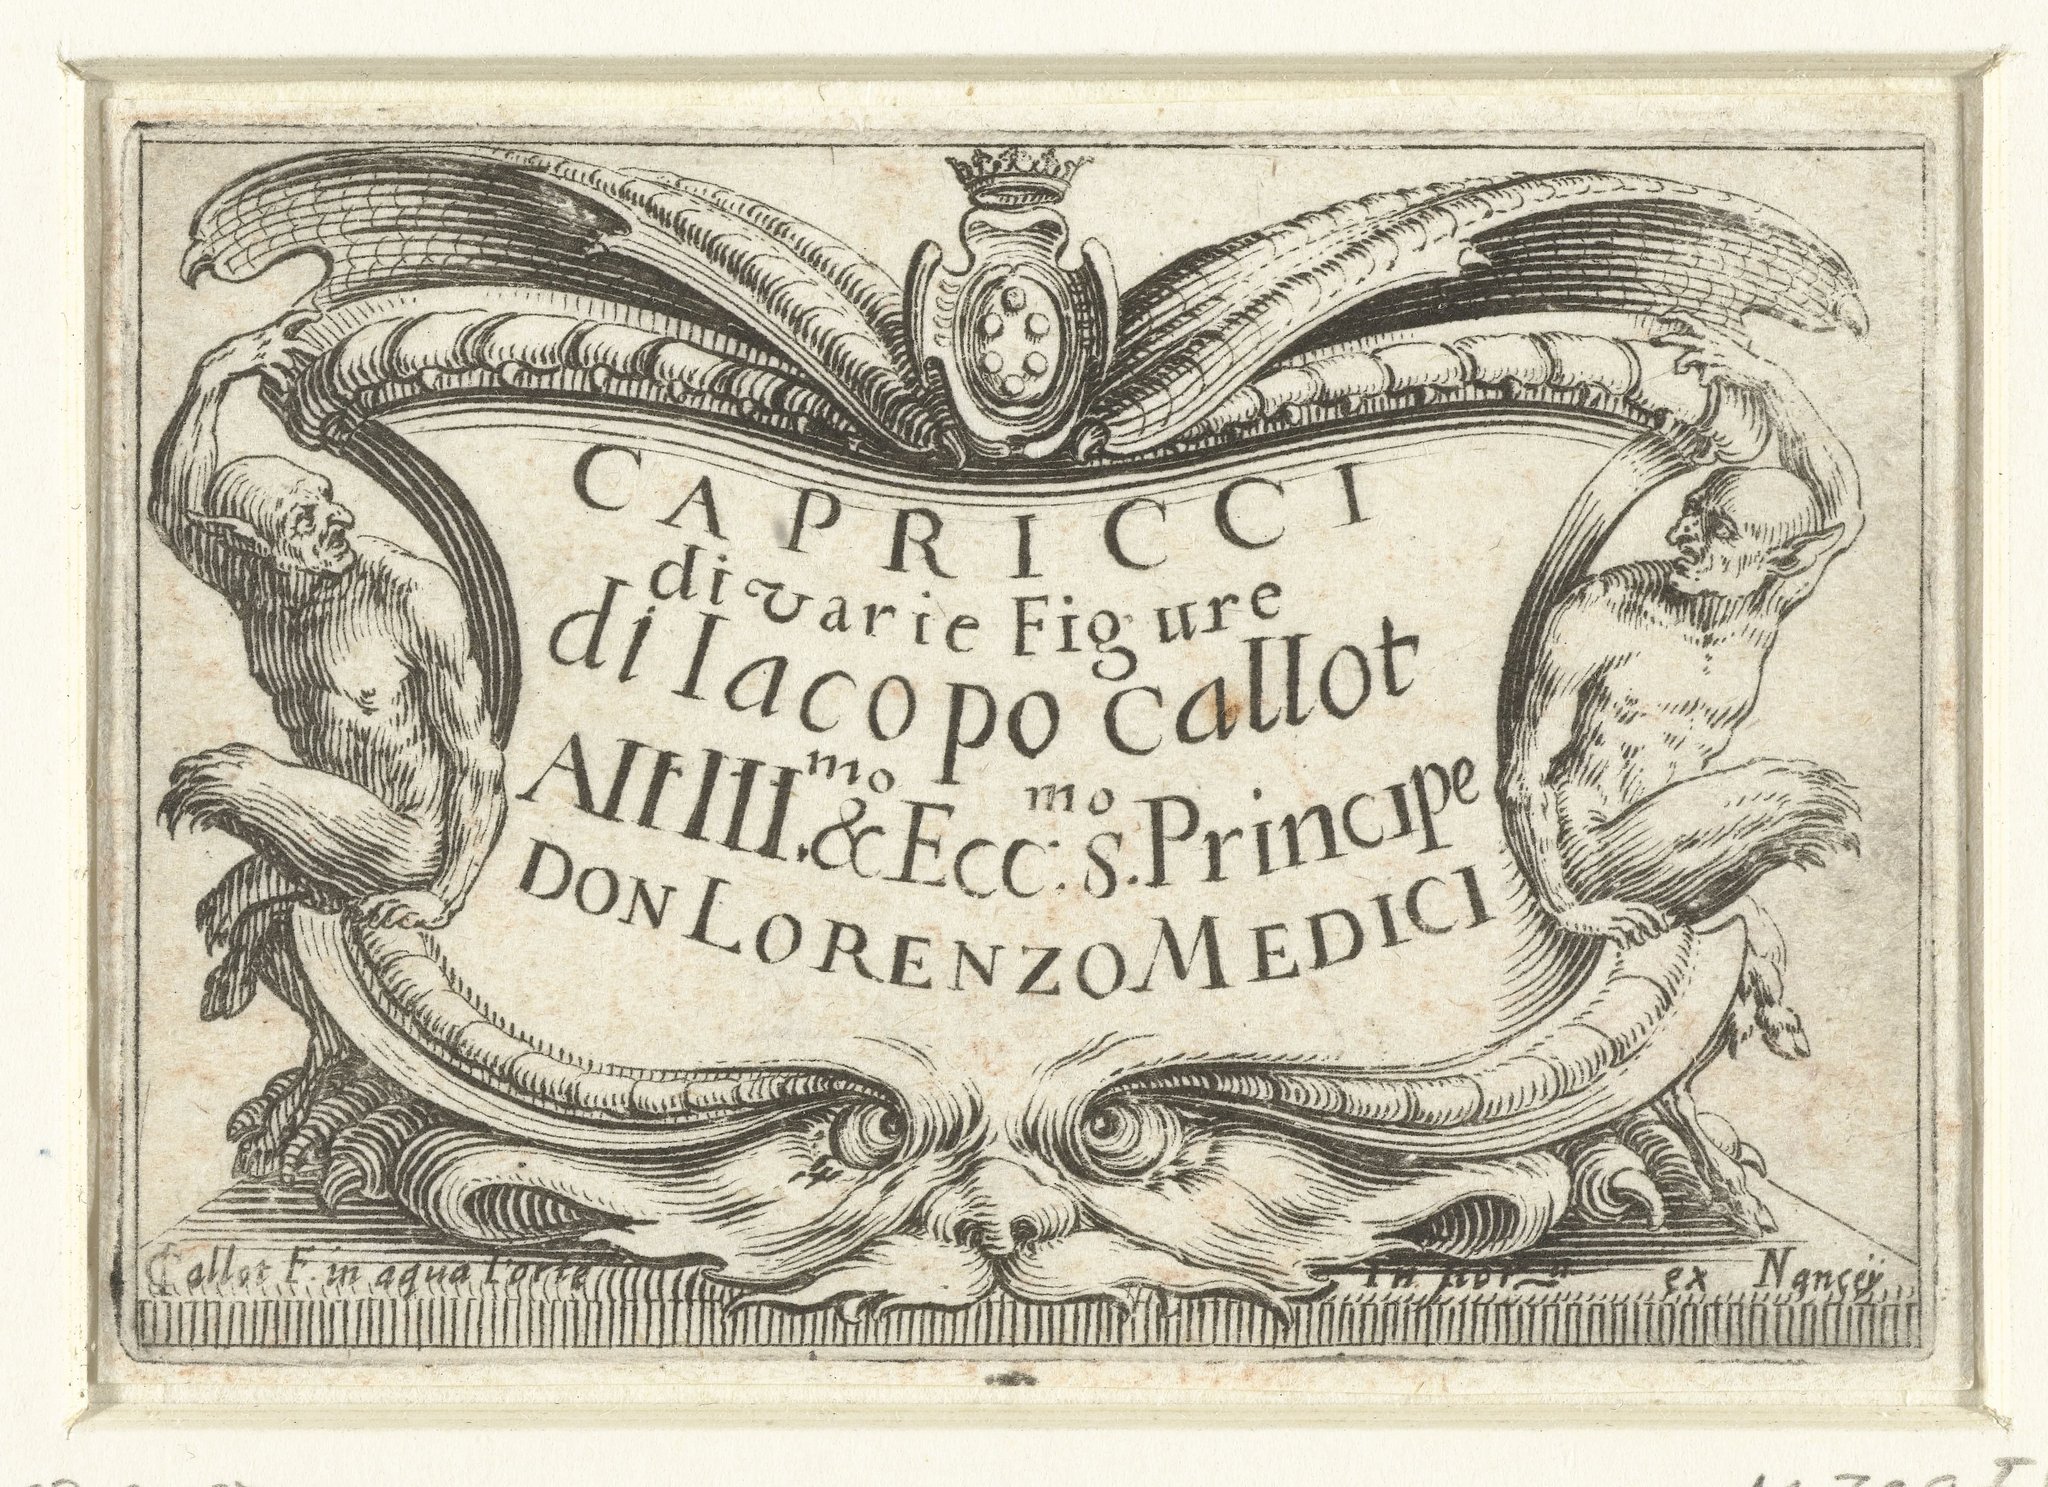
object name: titelprent, frontispice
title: Diverse figuren en voorstellingen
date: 1621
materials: paper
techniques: etching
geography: nancy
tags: lorenzo de' medici, satyr(s) (in general), ornament ~ cartouche, armorial bearing, heraldry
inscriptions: collector's mark: Lugt 240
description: Twee saters houden een cartouche vast, dat bekroond wordt door het wapen van de Medici en waarin titel en maker van de prentreeks staan genoteerd. Dit is namelijk de titelprent voor een serie van 48 prenten (49 incl. dedicatieblad) met diverse onderwerpen (o.a. mannen en vrouwen in verschillende houdingen, landschappen, gebouwen en festiviteiten in Florence). Mogelijk zijn deze prenten bedoeld geweest als tekenvoorbeelden.